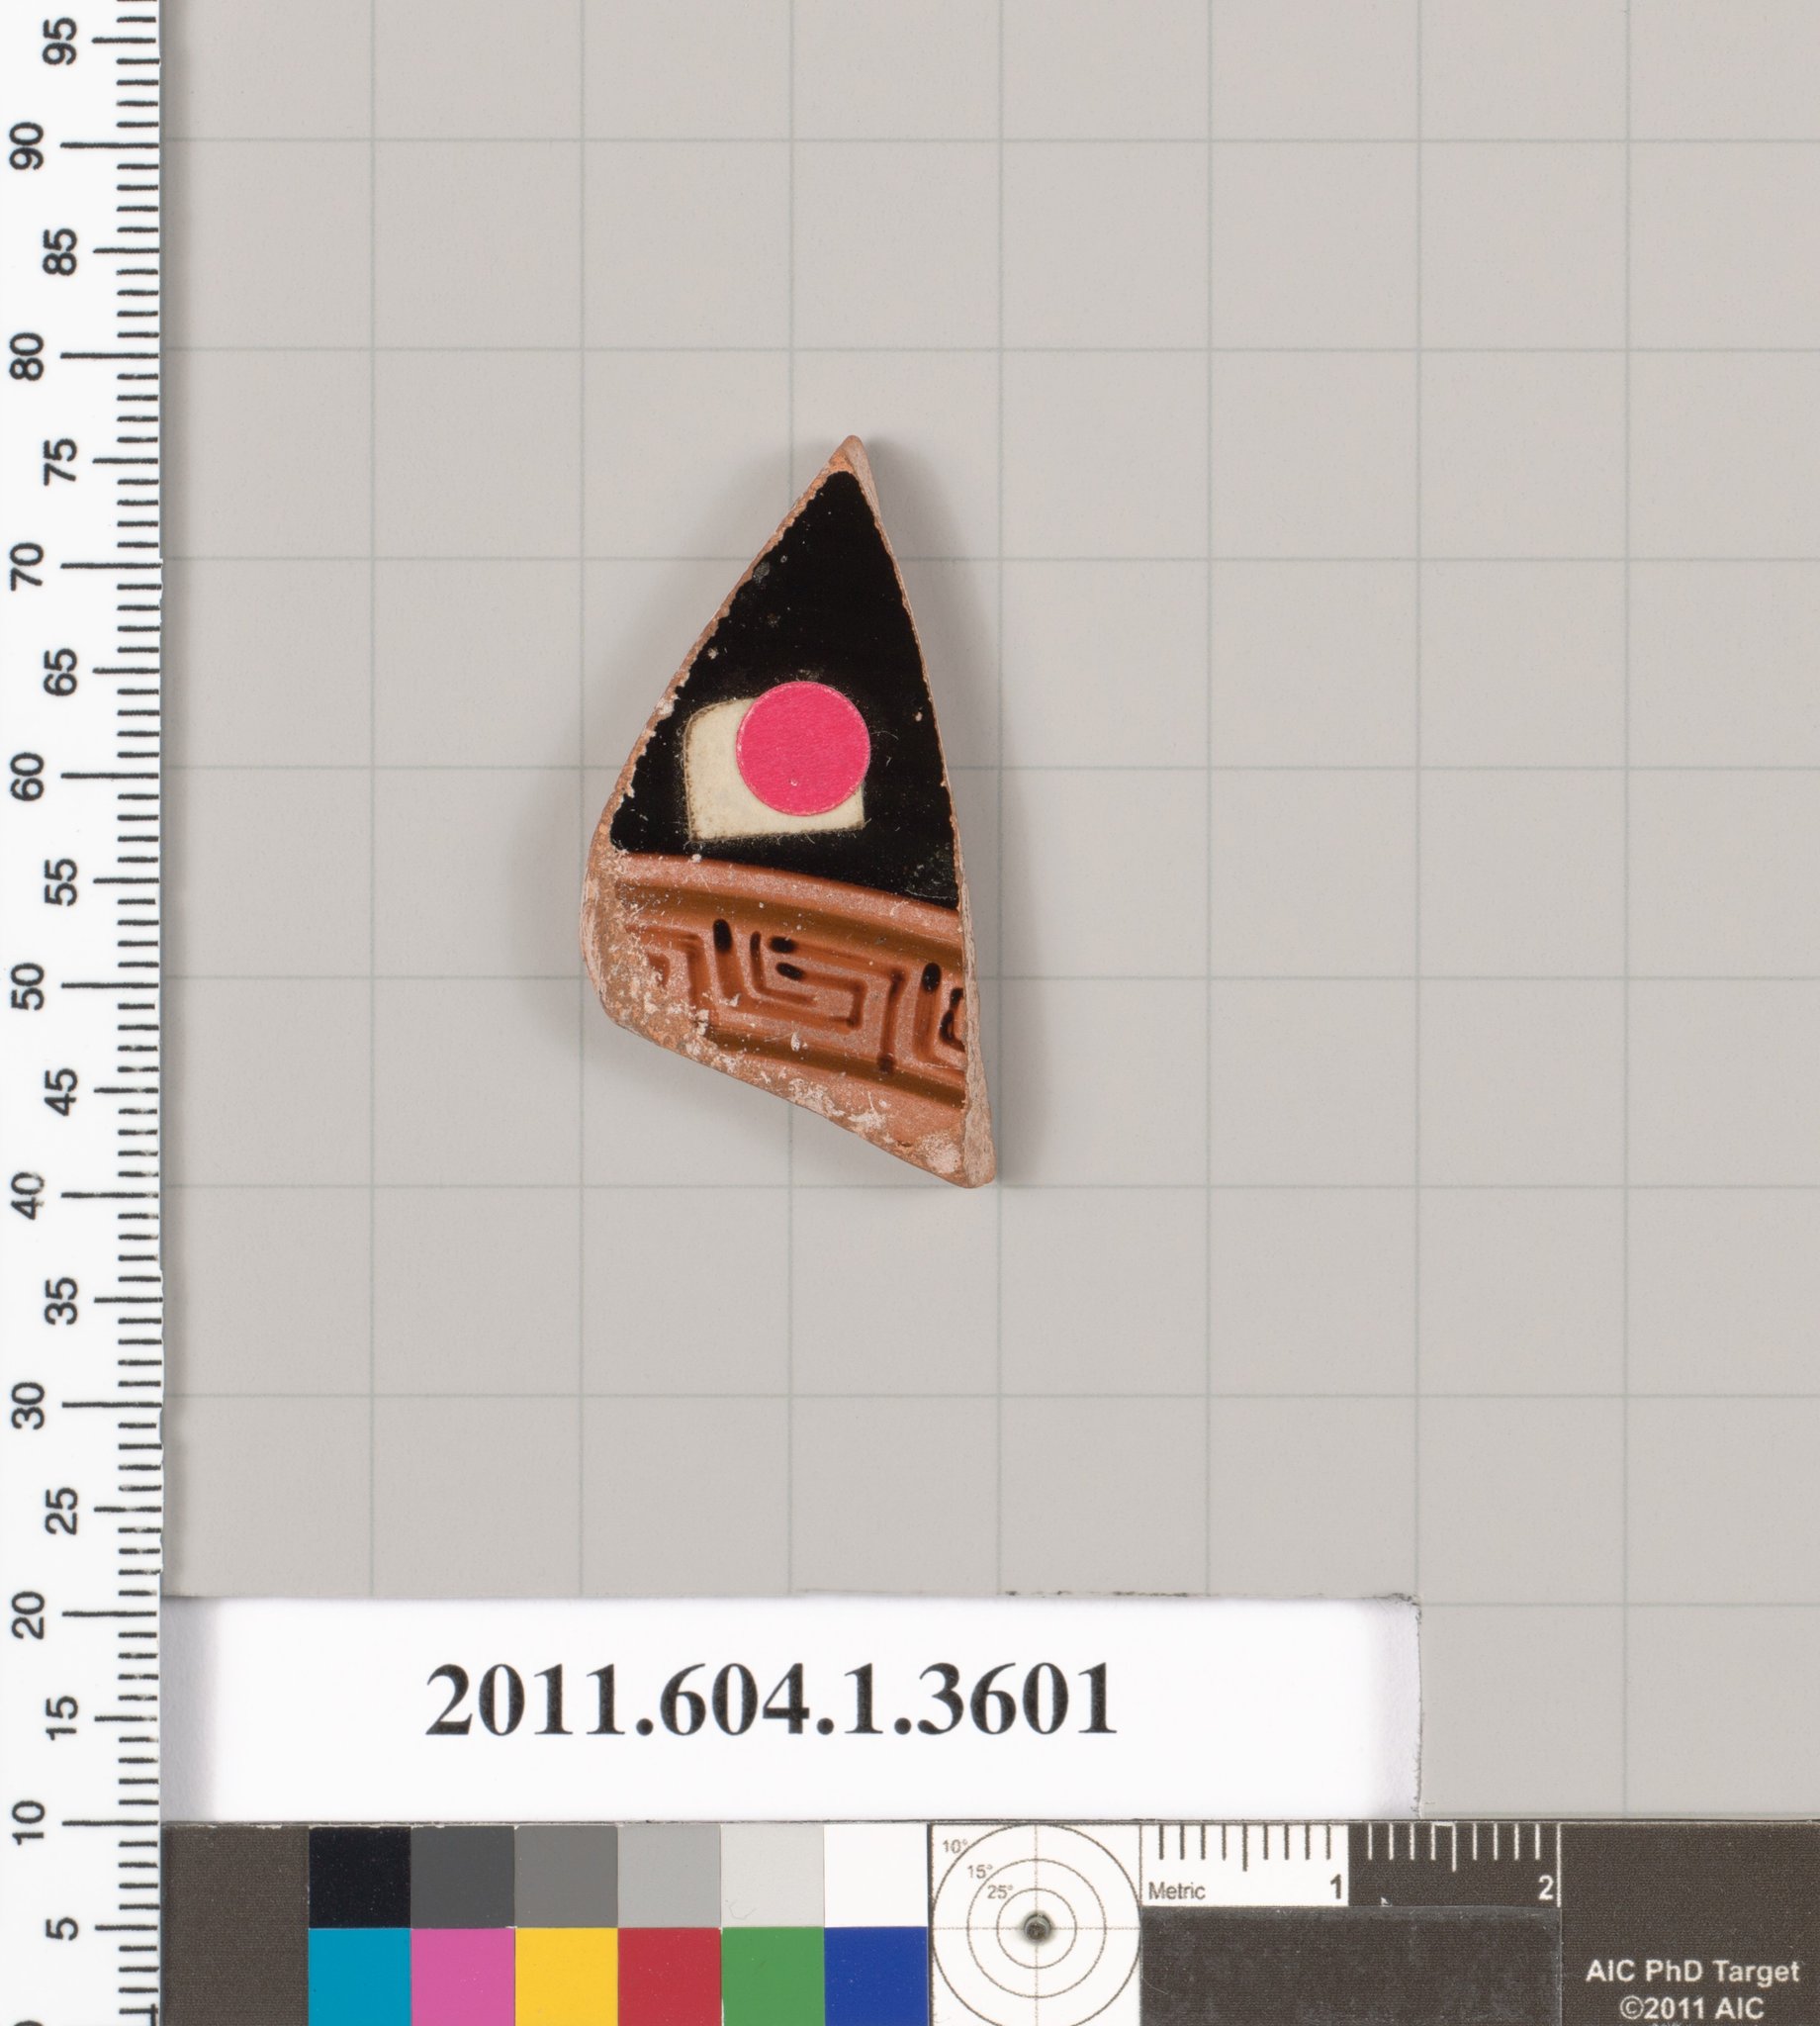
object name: kylix fragment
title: Terracotta fragment of a kylix (drinking cup)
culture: greek, attic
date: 490-470 BCE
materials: terracotta